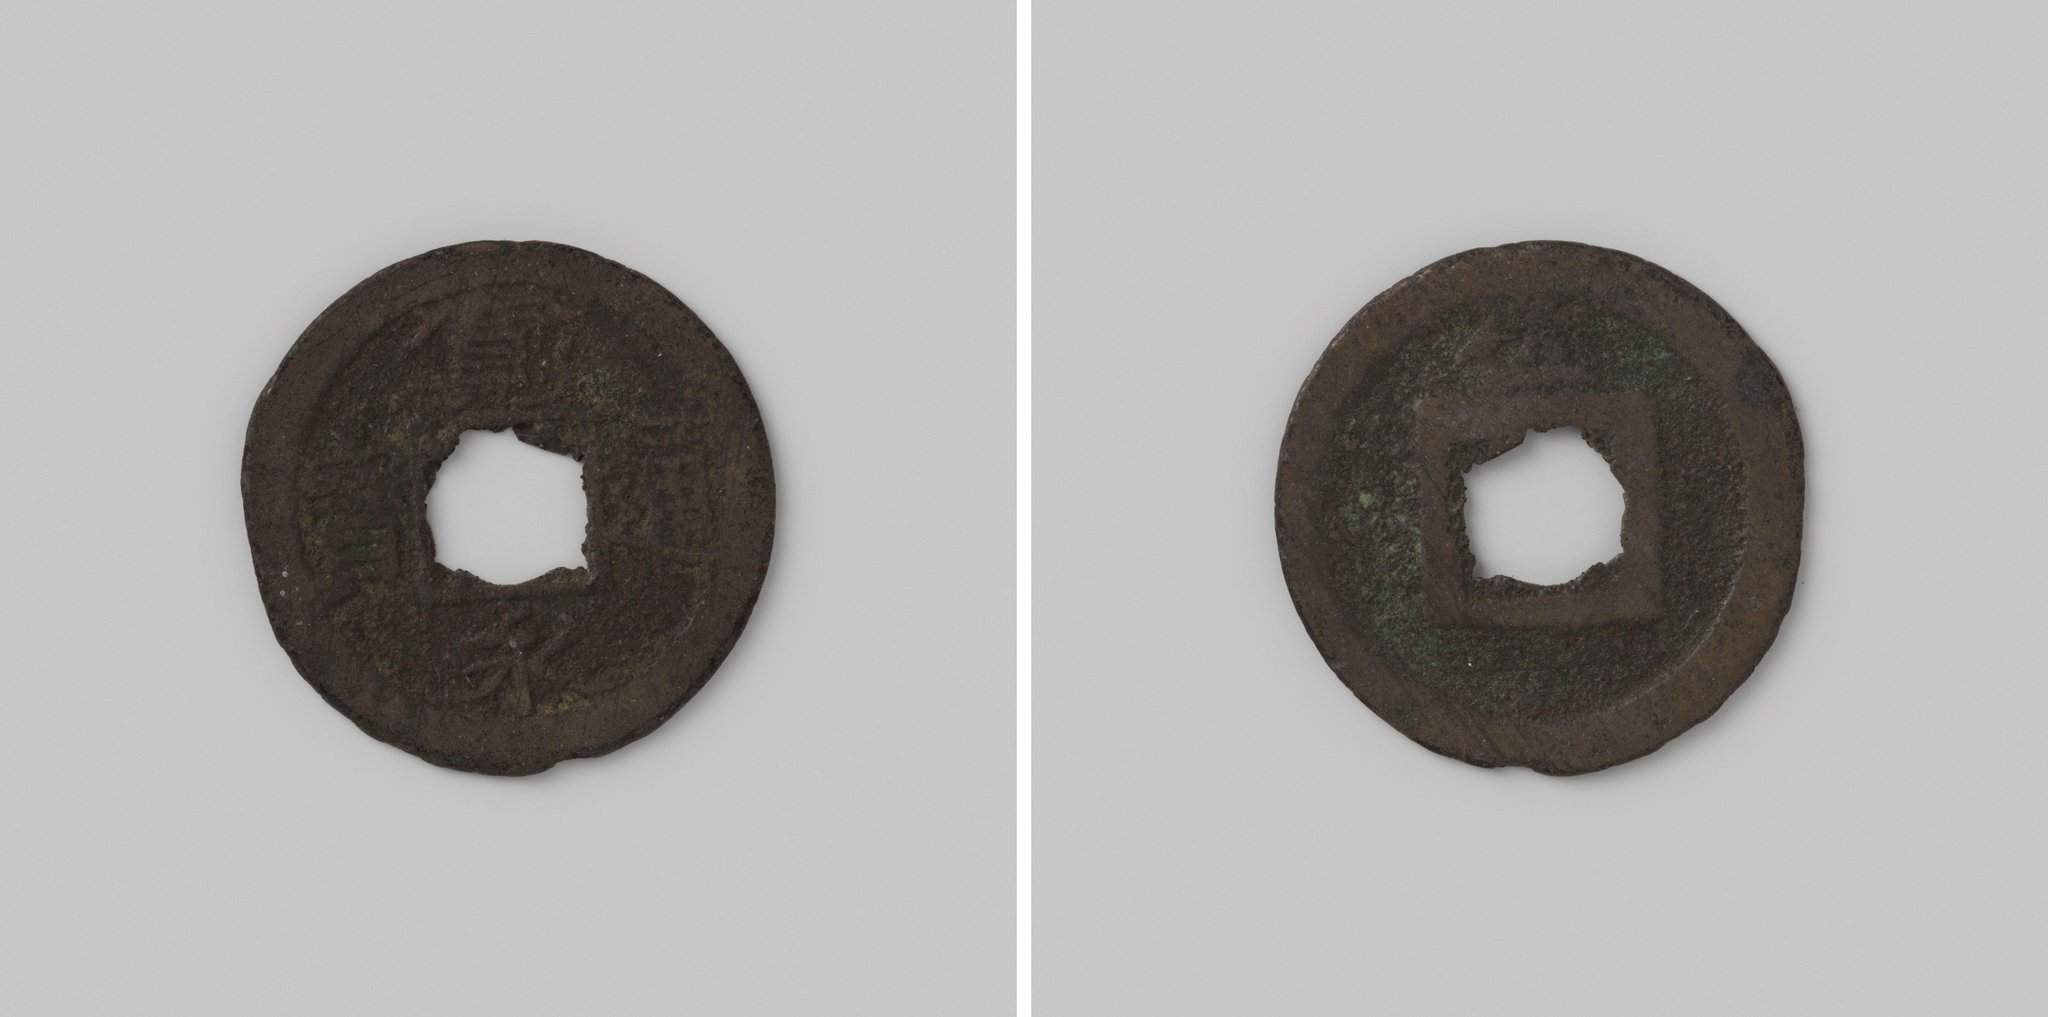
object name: sen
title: Sen van 1 mon van het keizerrijk Japan uit Sendai, hoofdstad van de provincie Rikuzen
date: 1784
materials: iron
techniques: casting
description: IJzeren, bijna vierkante munt. Voorzijde: binnen brede gladde rand rondom vierkante uitsparing in het midden vier kruisgewijze geplaatste tekens. Keerzijde: binnen berde gladde rand glad oppervlak??